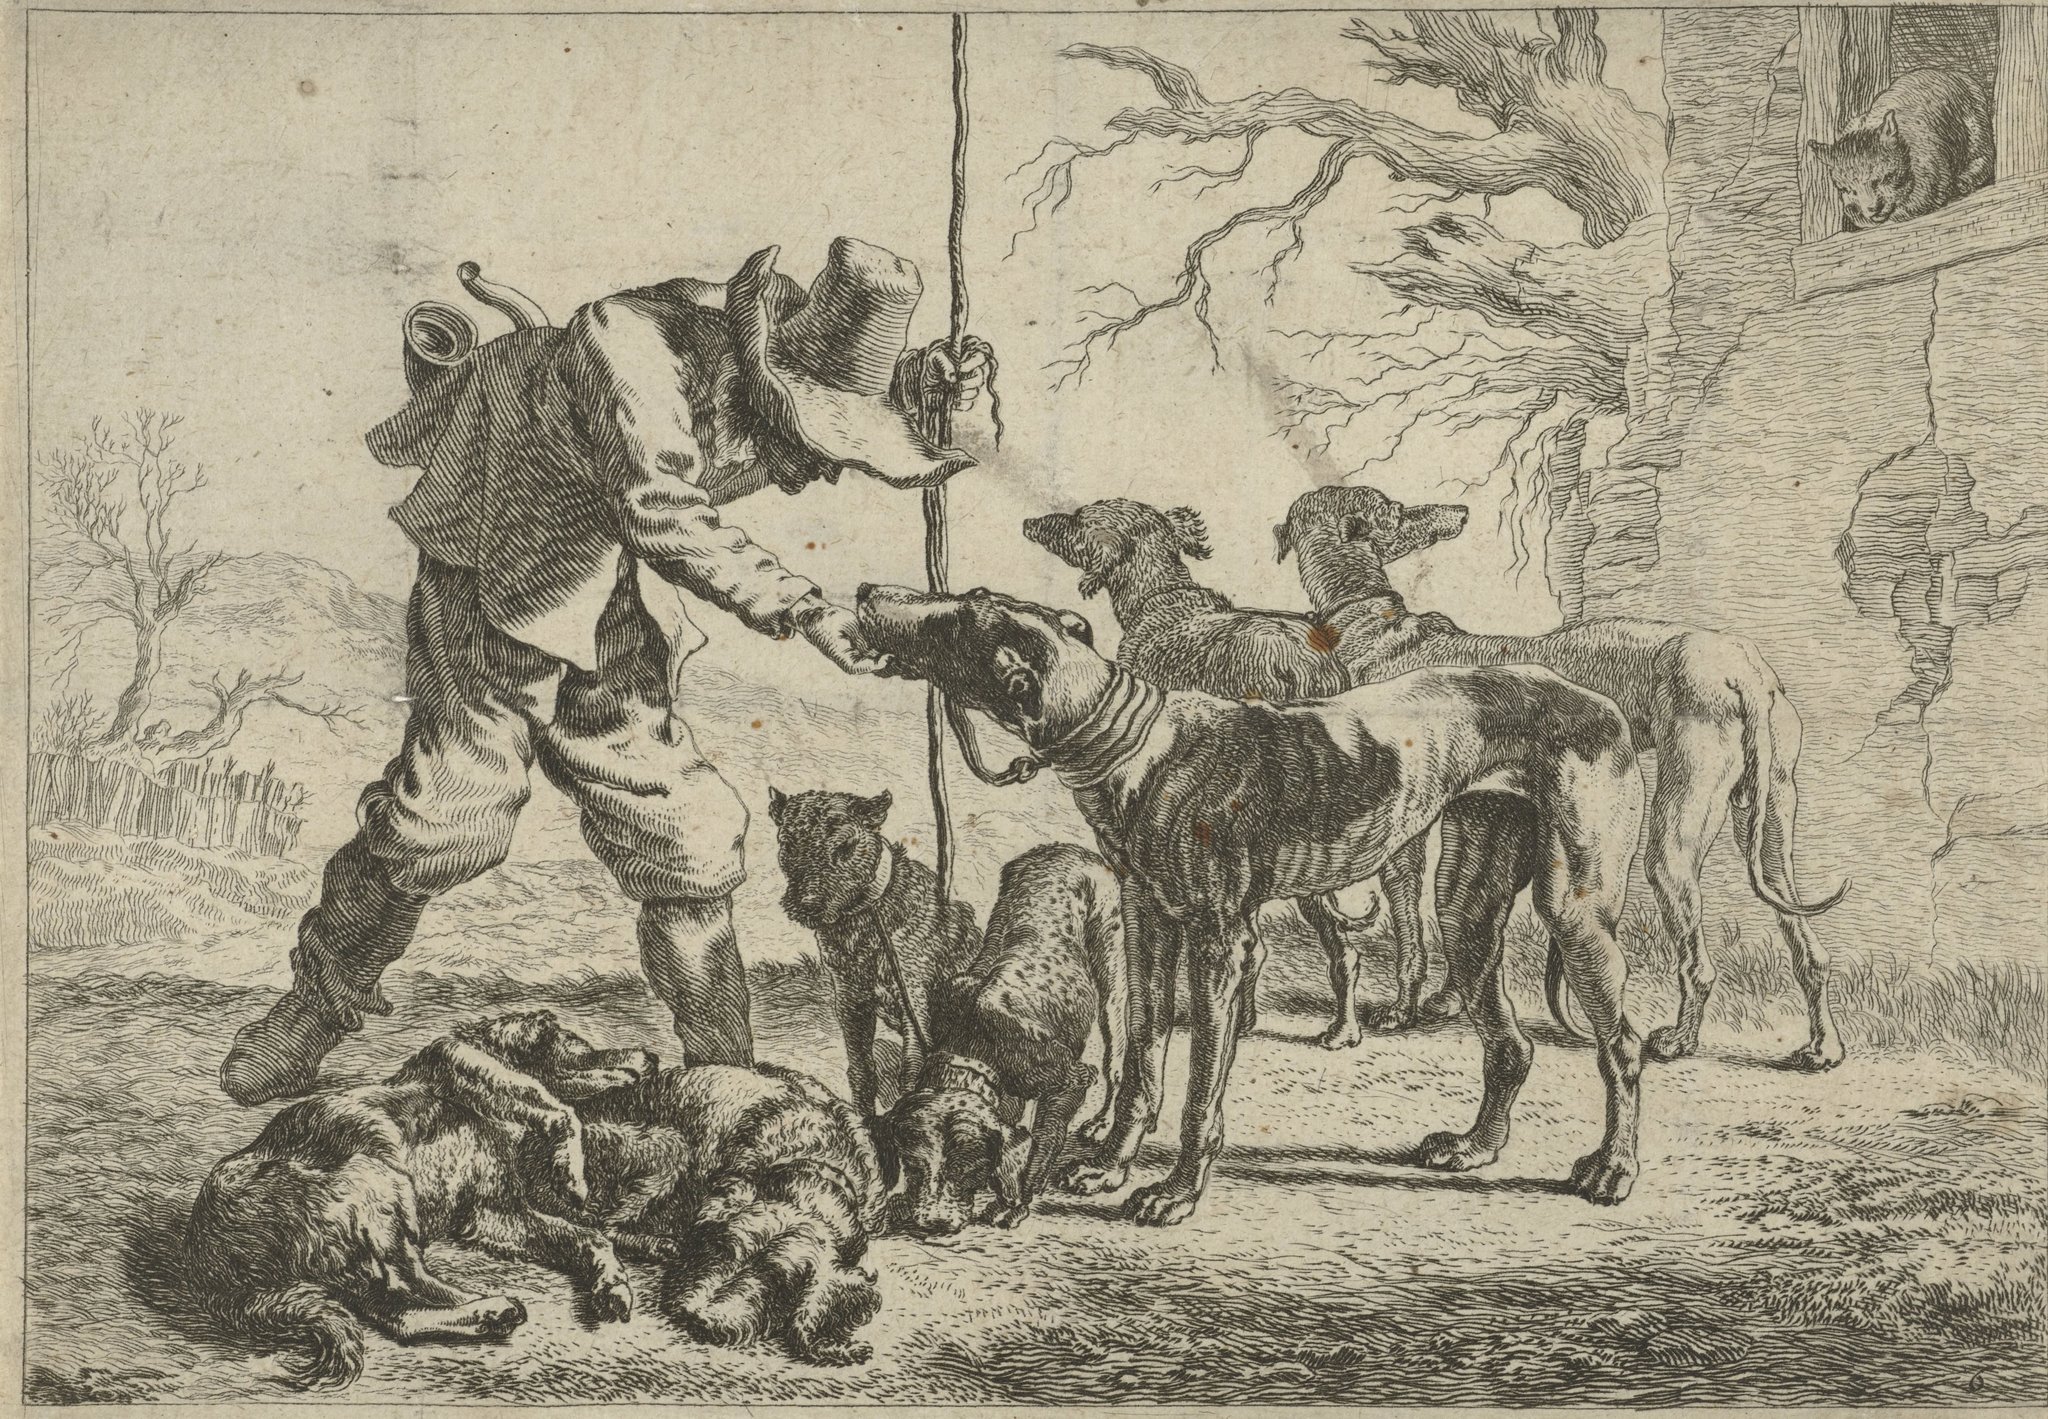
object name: print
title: Verschillende dieren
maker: Anonymous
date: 1636-1692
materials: paper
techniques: etching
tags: cat, hunting dogs, hunter, friendship between man and animal; caressing, petting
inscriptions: collector's mark: Lugt 2228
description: Kopie naar gelijknamige prent uit een achtdelige serie met voorstellingen van verschillende dieren door Pieter Bodding van Laer.